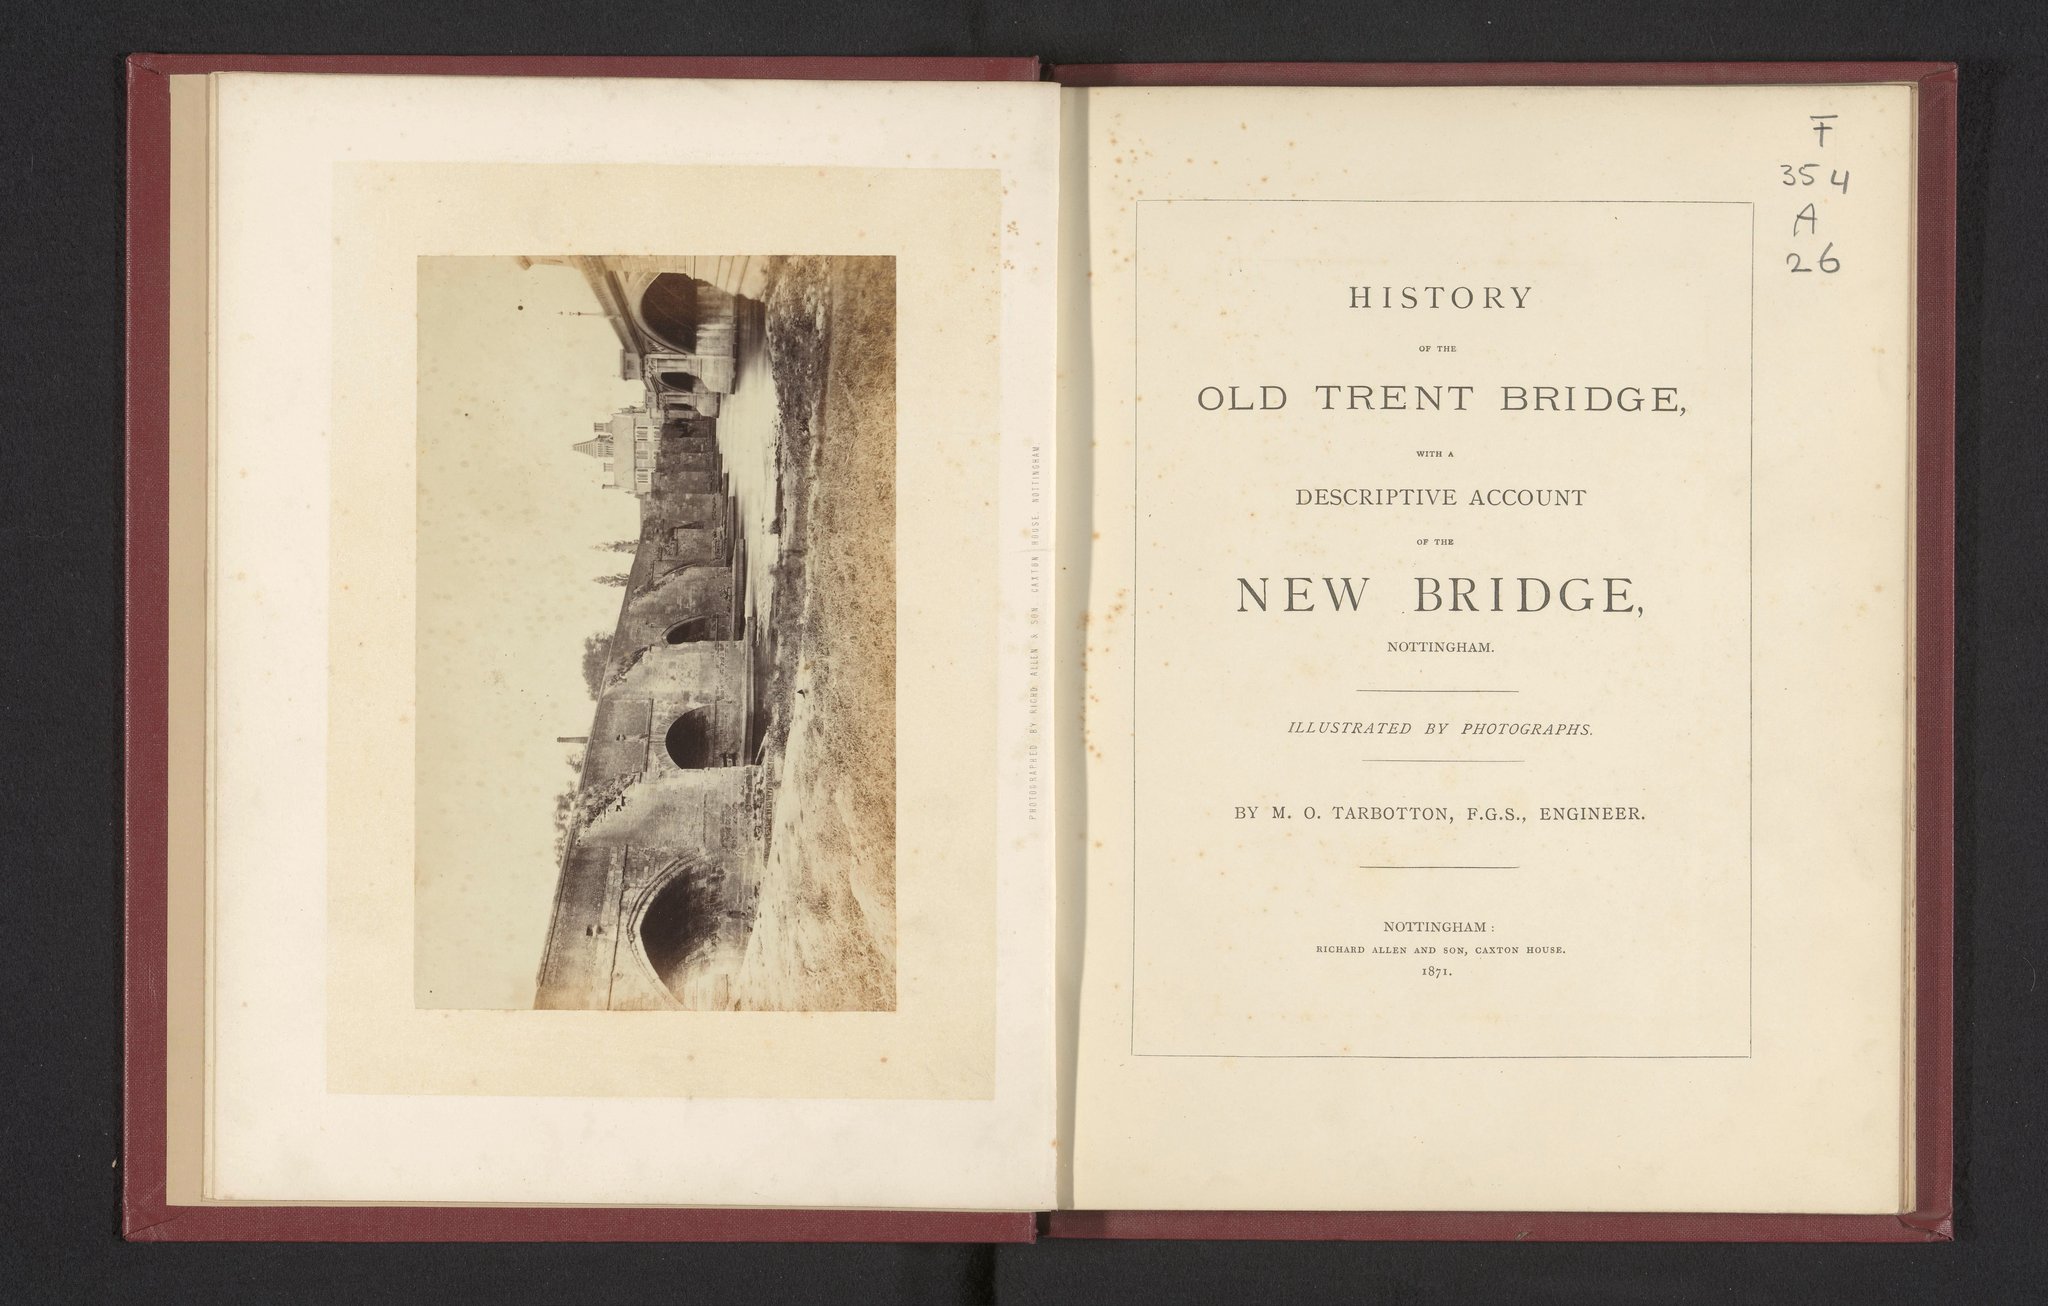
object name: book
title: History of the old Trent bridge with a descriptive account of the new bridge, Nottingham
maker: marriott ogle tarbotton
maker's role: engineer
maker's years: 1834-1887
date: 1871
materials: linen, paper, photographic support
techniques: albumen print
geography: nottingham